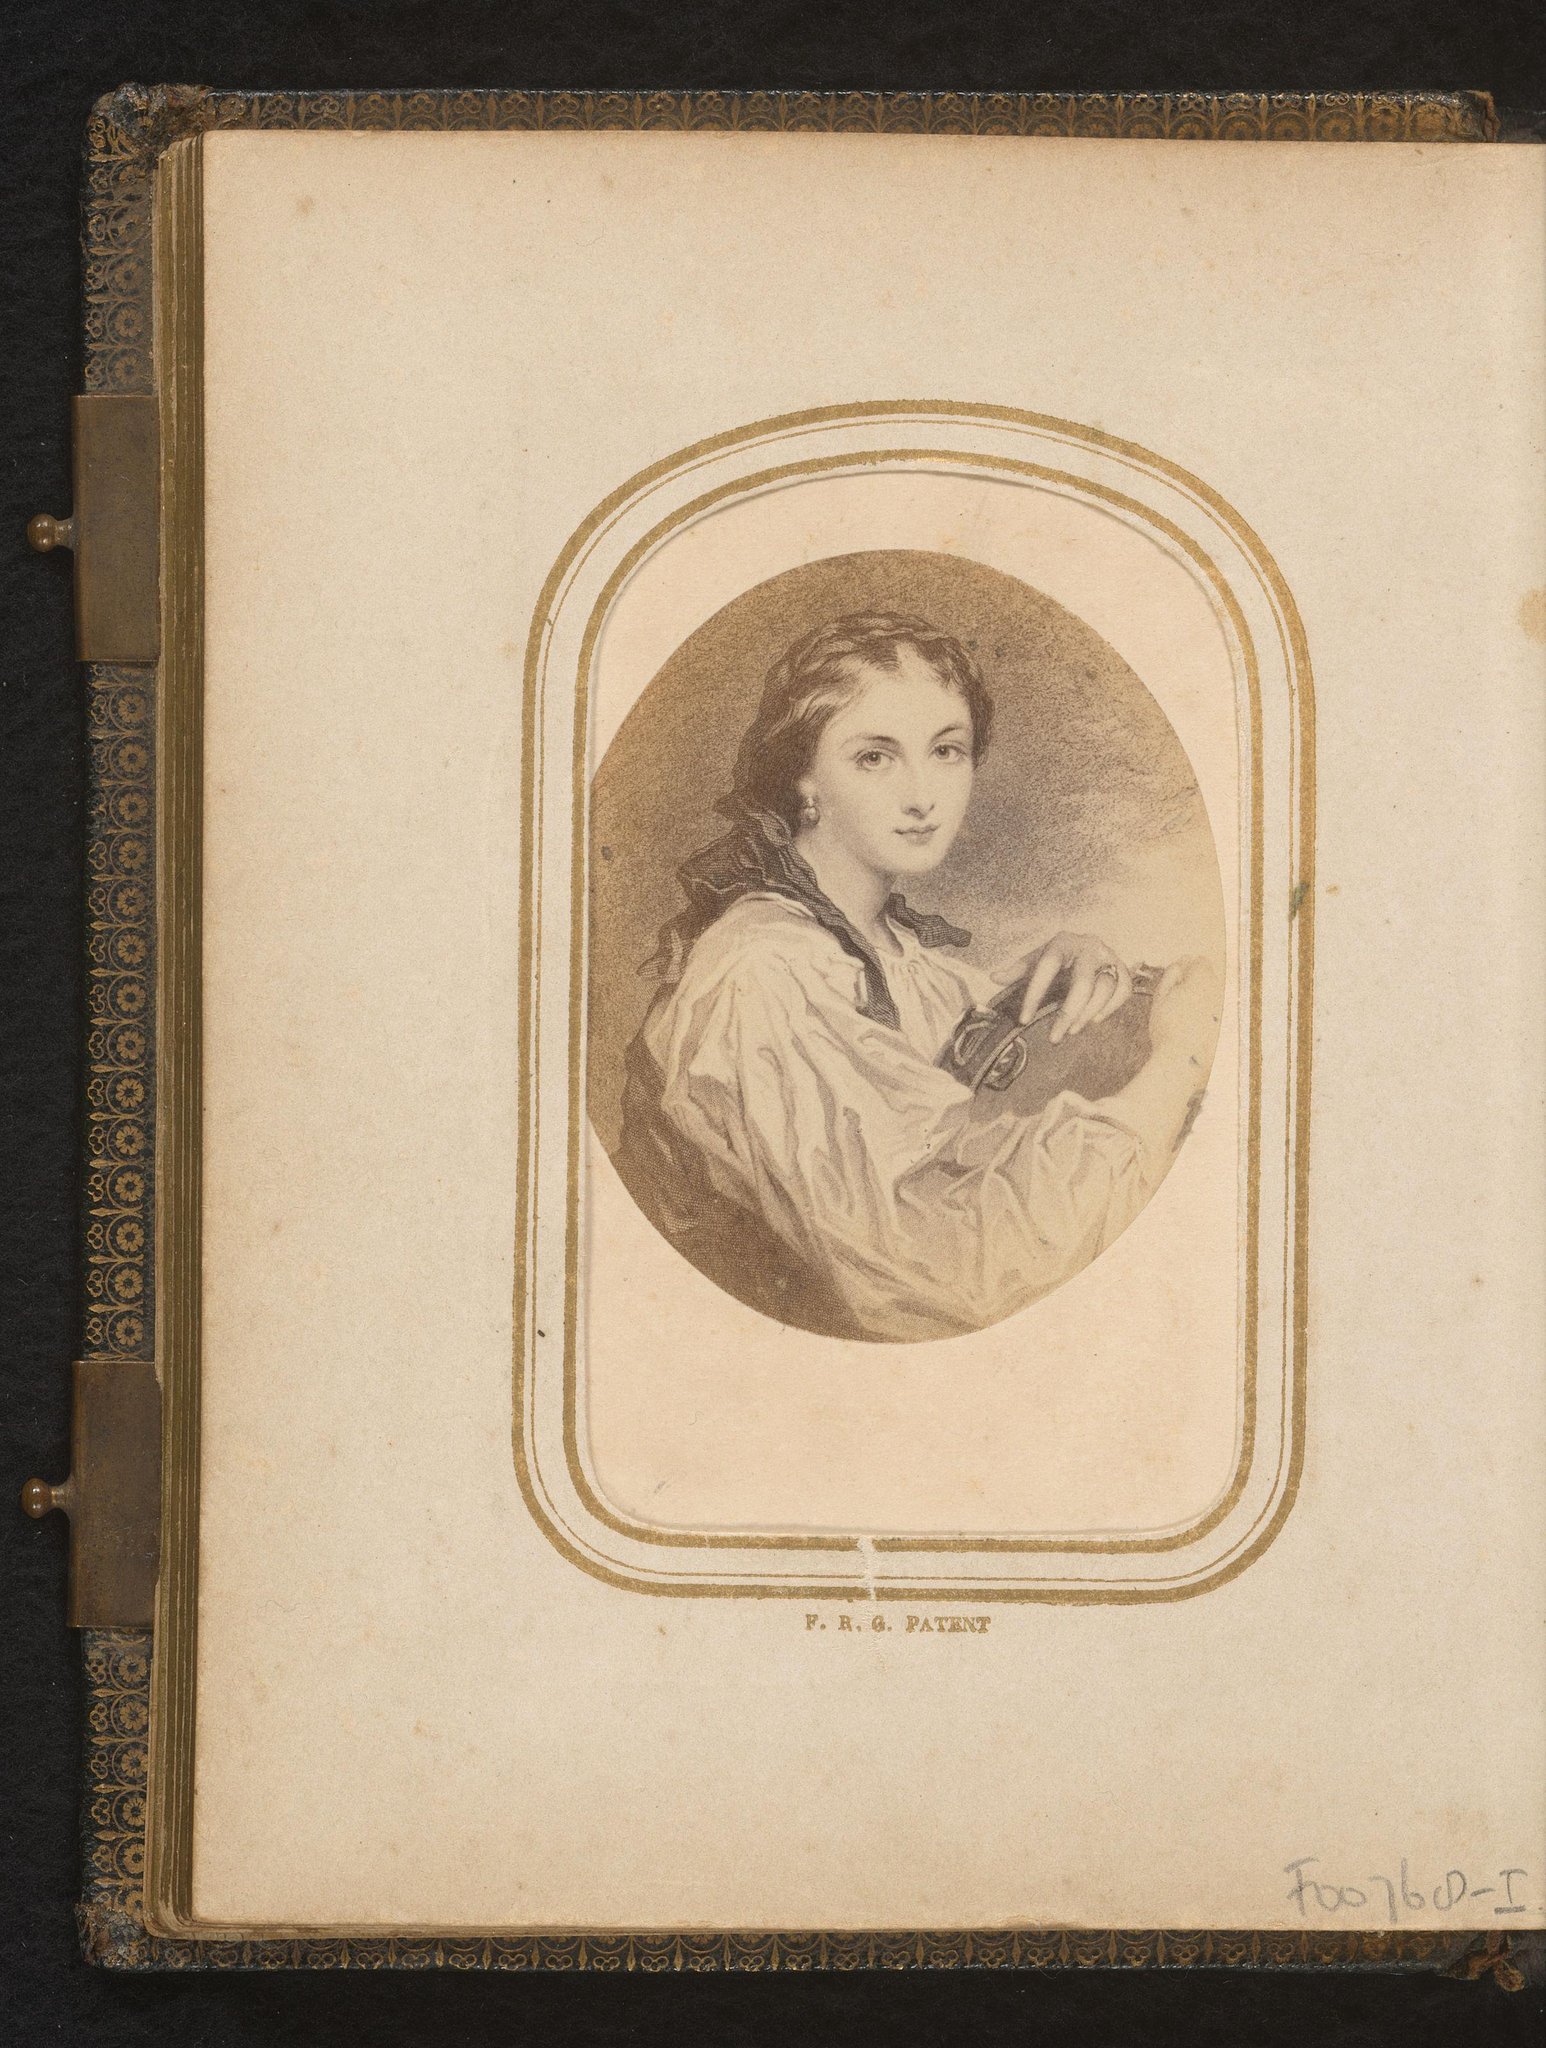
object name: album leaf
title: Fotoreproductie van een getekend portret van een vrouw met een tamboerijn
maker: Anonymous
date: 1865-1890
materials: cardboard, photographic support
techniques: albumen print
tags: adult woman, tambourine, painting, drawing and the graphic arts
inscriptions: number: ‘2143’